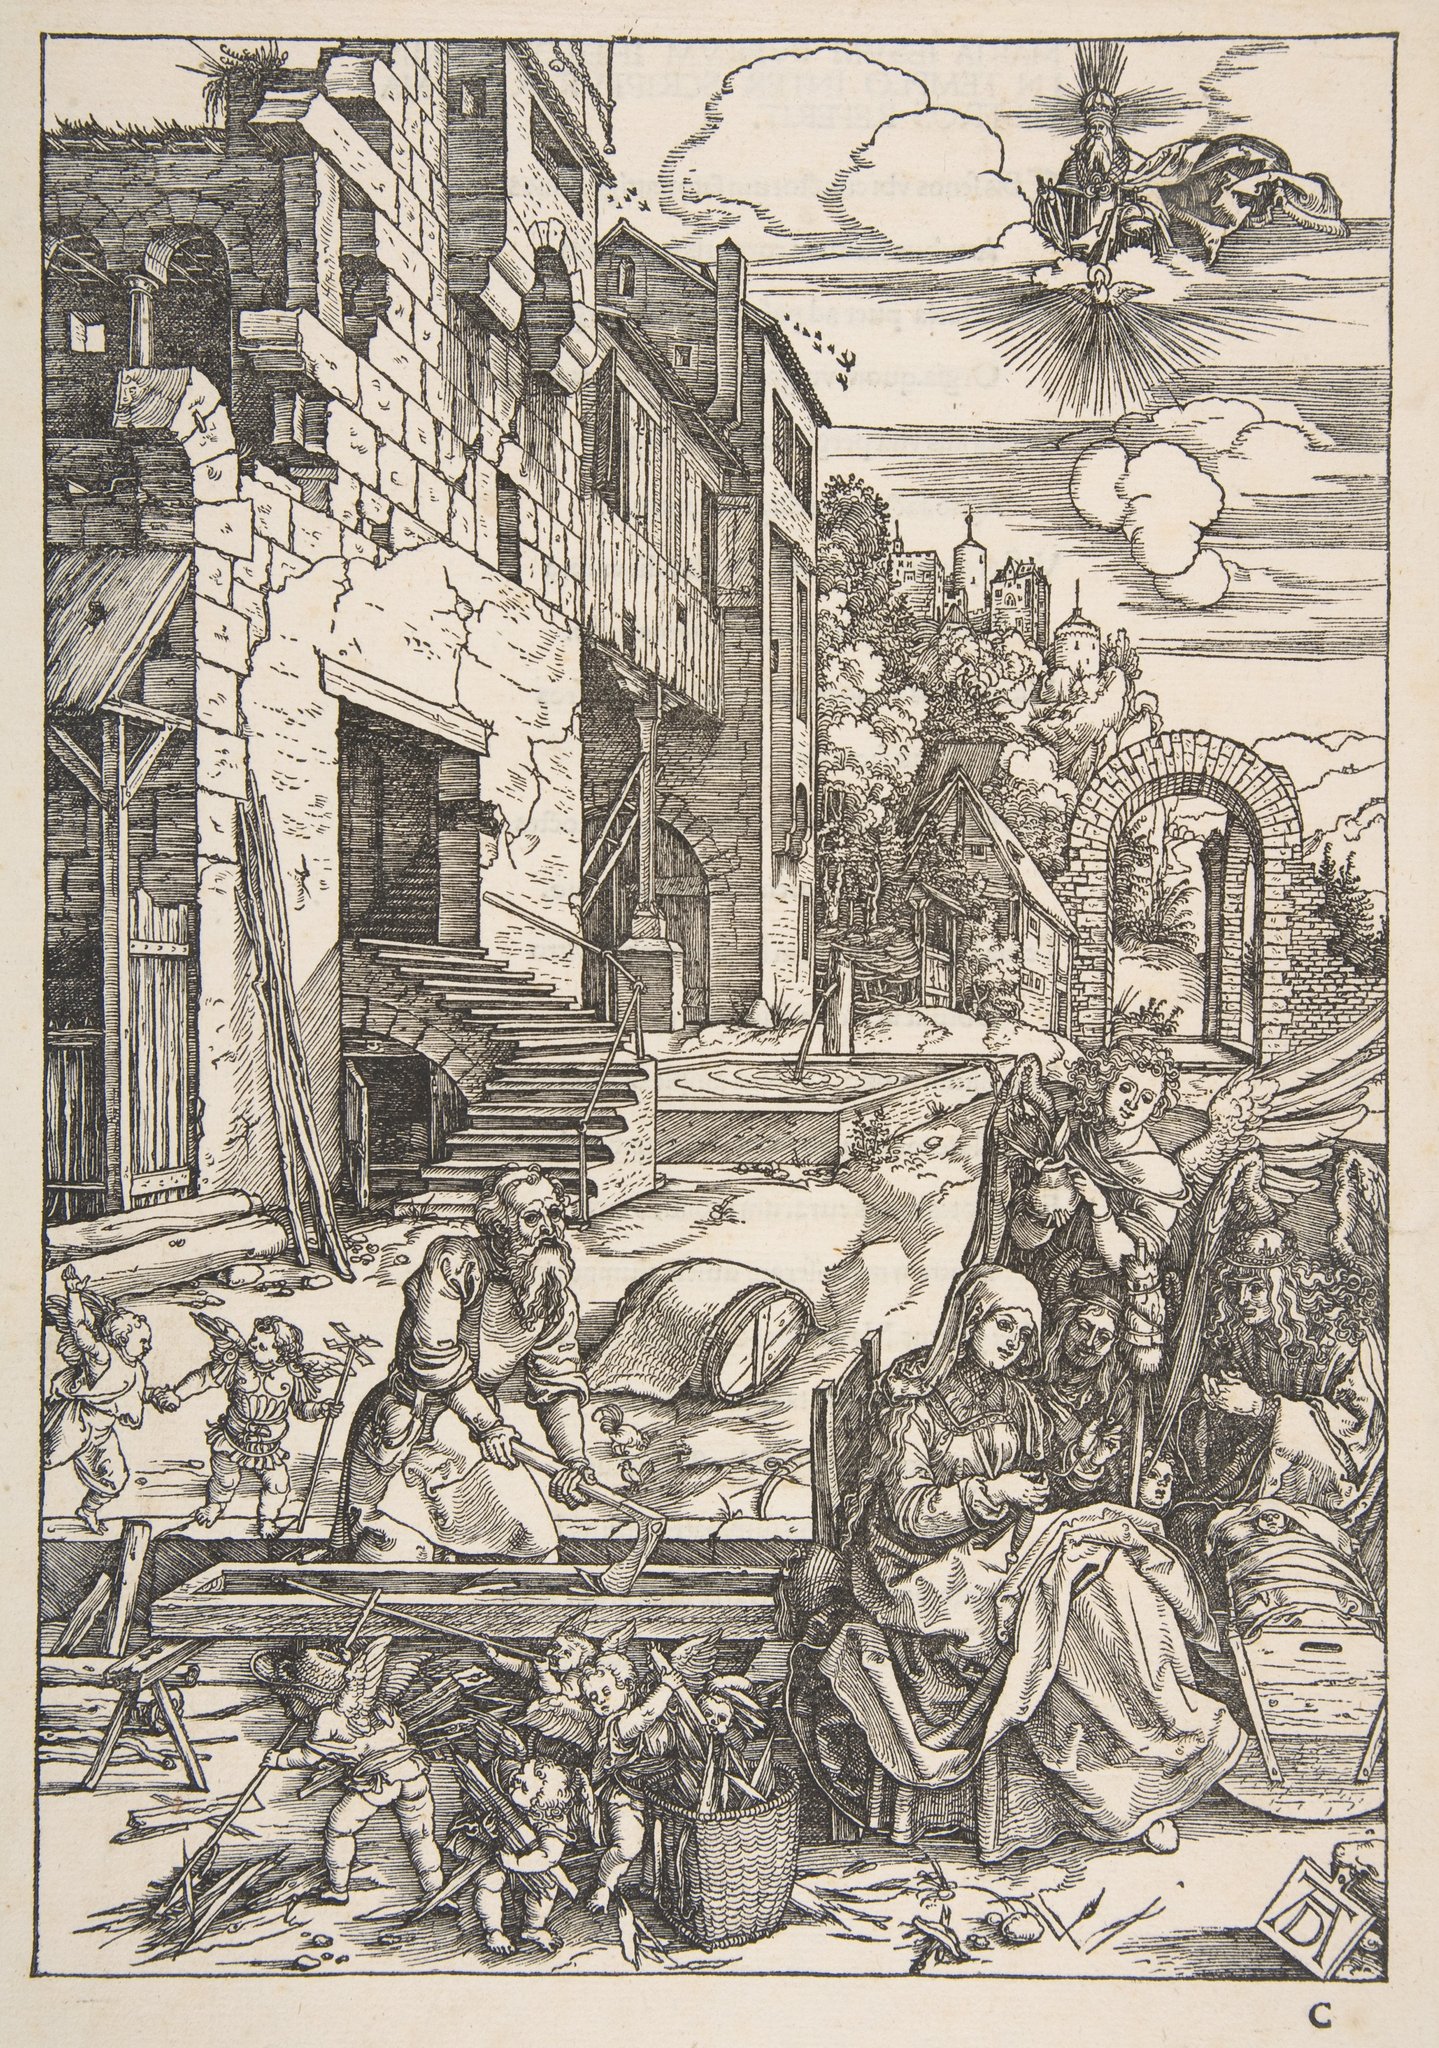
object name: print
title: The Sojourn of The Holy Family in Egypt, from "The Life of the Virgin"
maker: albrecht dürer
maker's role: artist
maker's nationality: german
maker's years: 1471-1528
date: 1511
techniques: woodcut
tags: ruins,angels,holy family,virgin mary